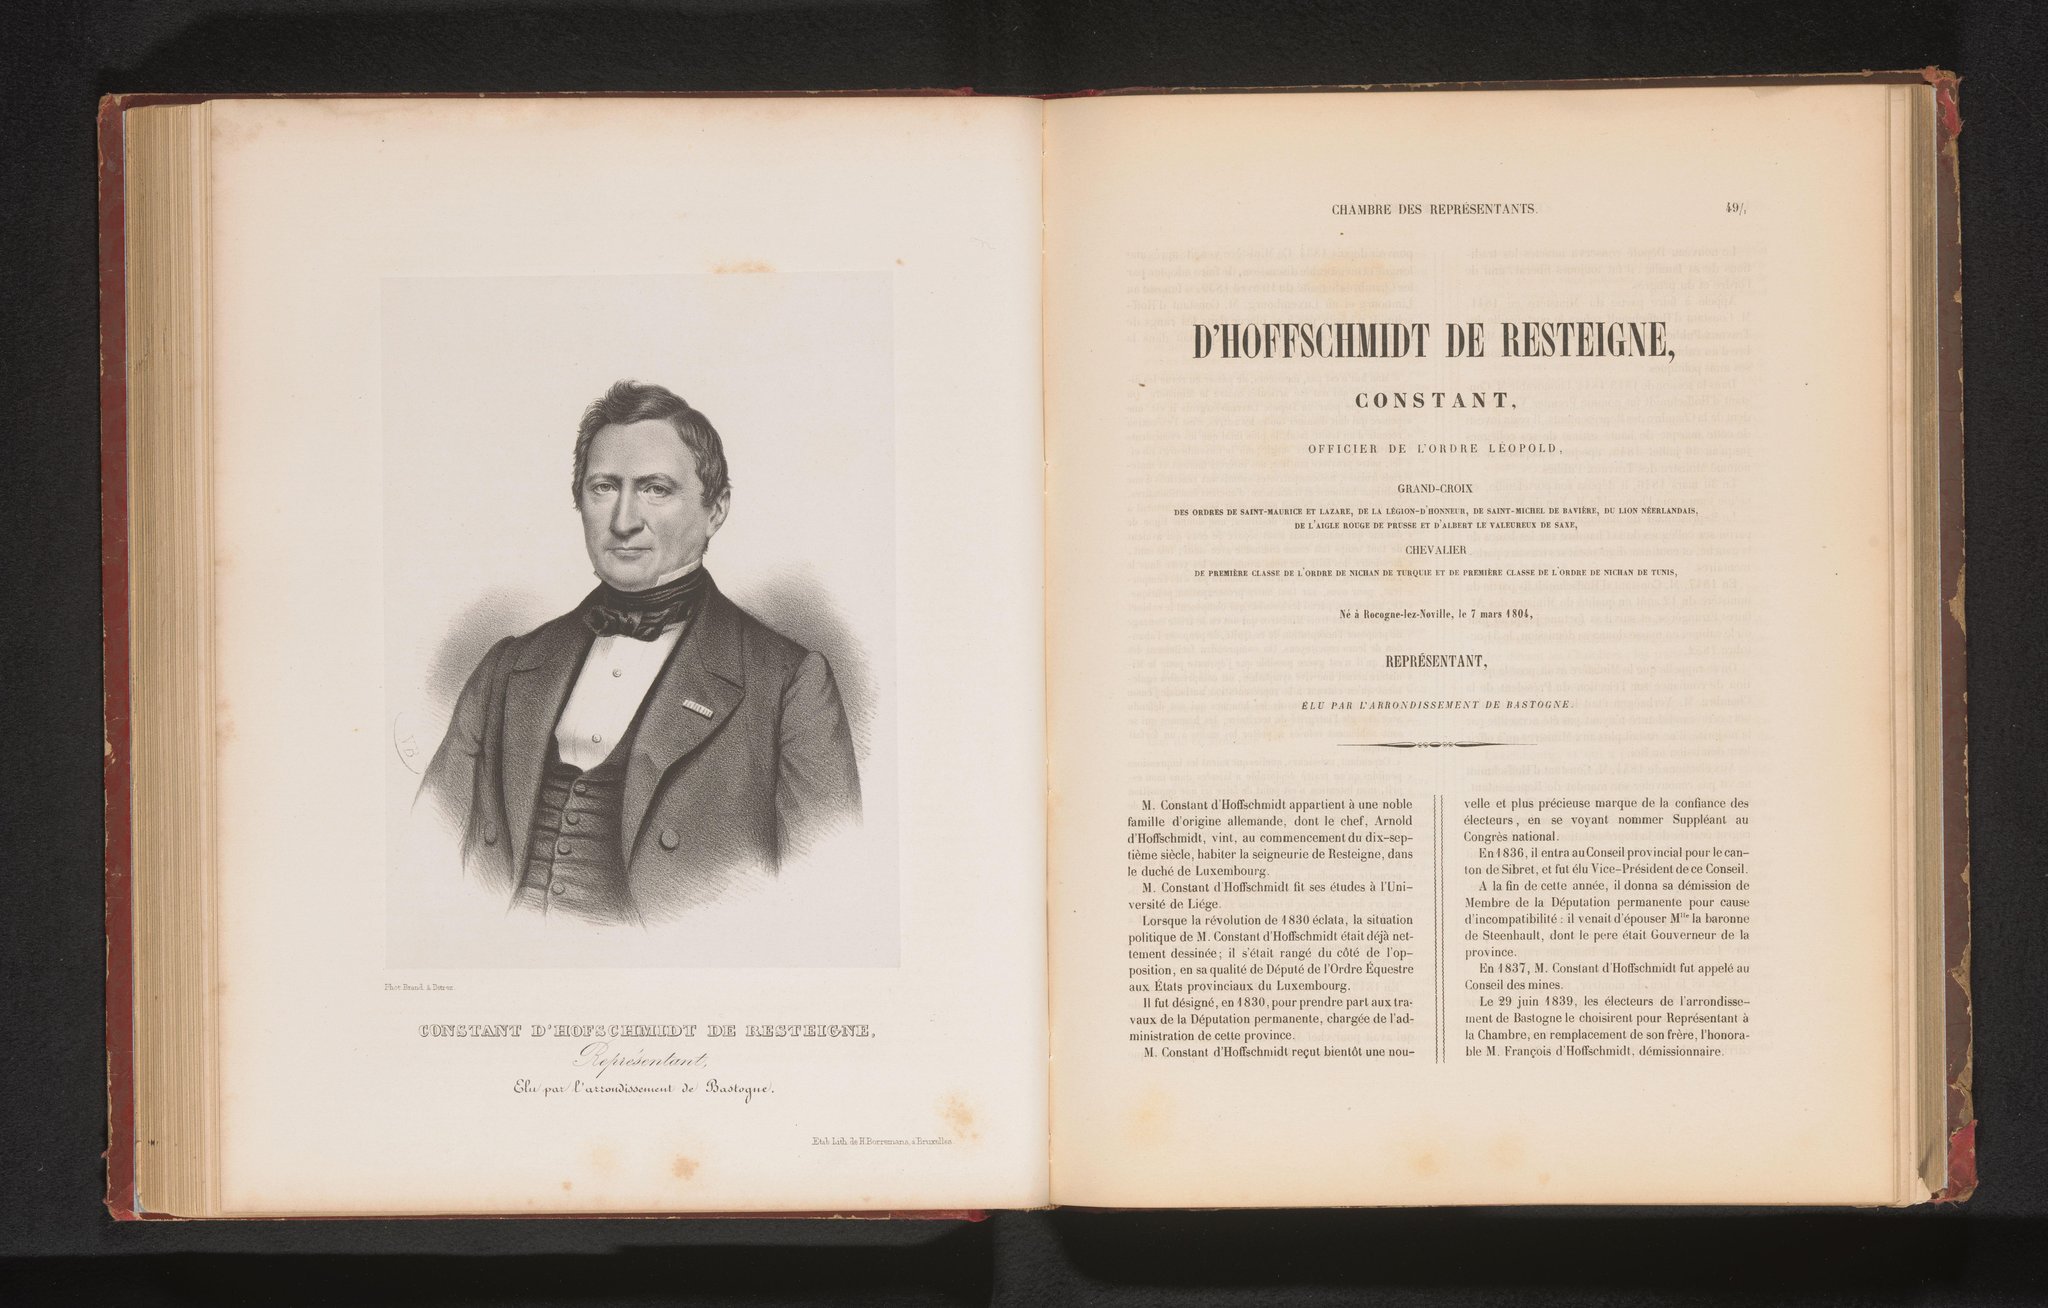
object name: print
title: Reproductie van een foto van een portret van Constant d'Hoffschmidt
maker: henri borremans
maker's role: print maker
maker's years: 1800-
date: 1853-1858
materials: paper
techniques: lithograph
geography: brussels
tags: politician, historical persons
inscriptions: inscription: ‘Représentant,/ Elu par l'arrondissement de Bastogne.’